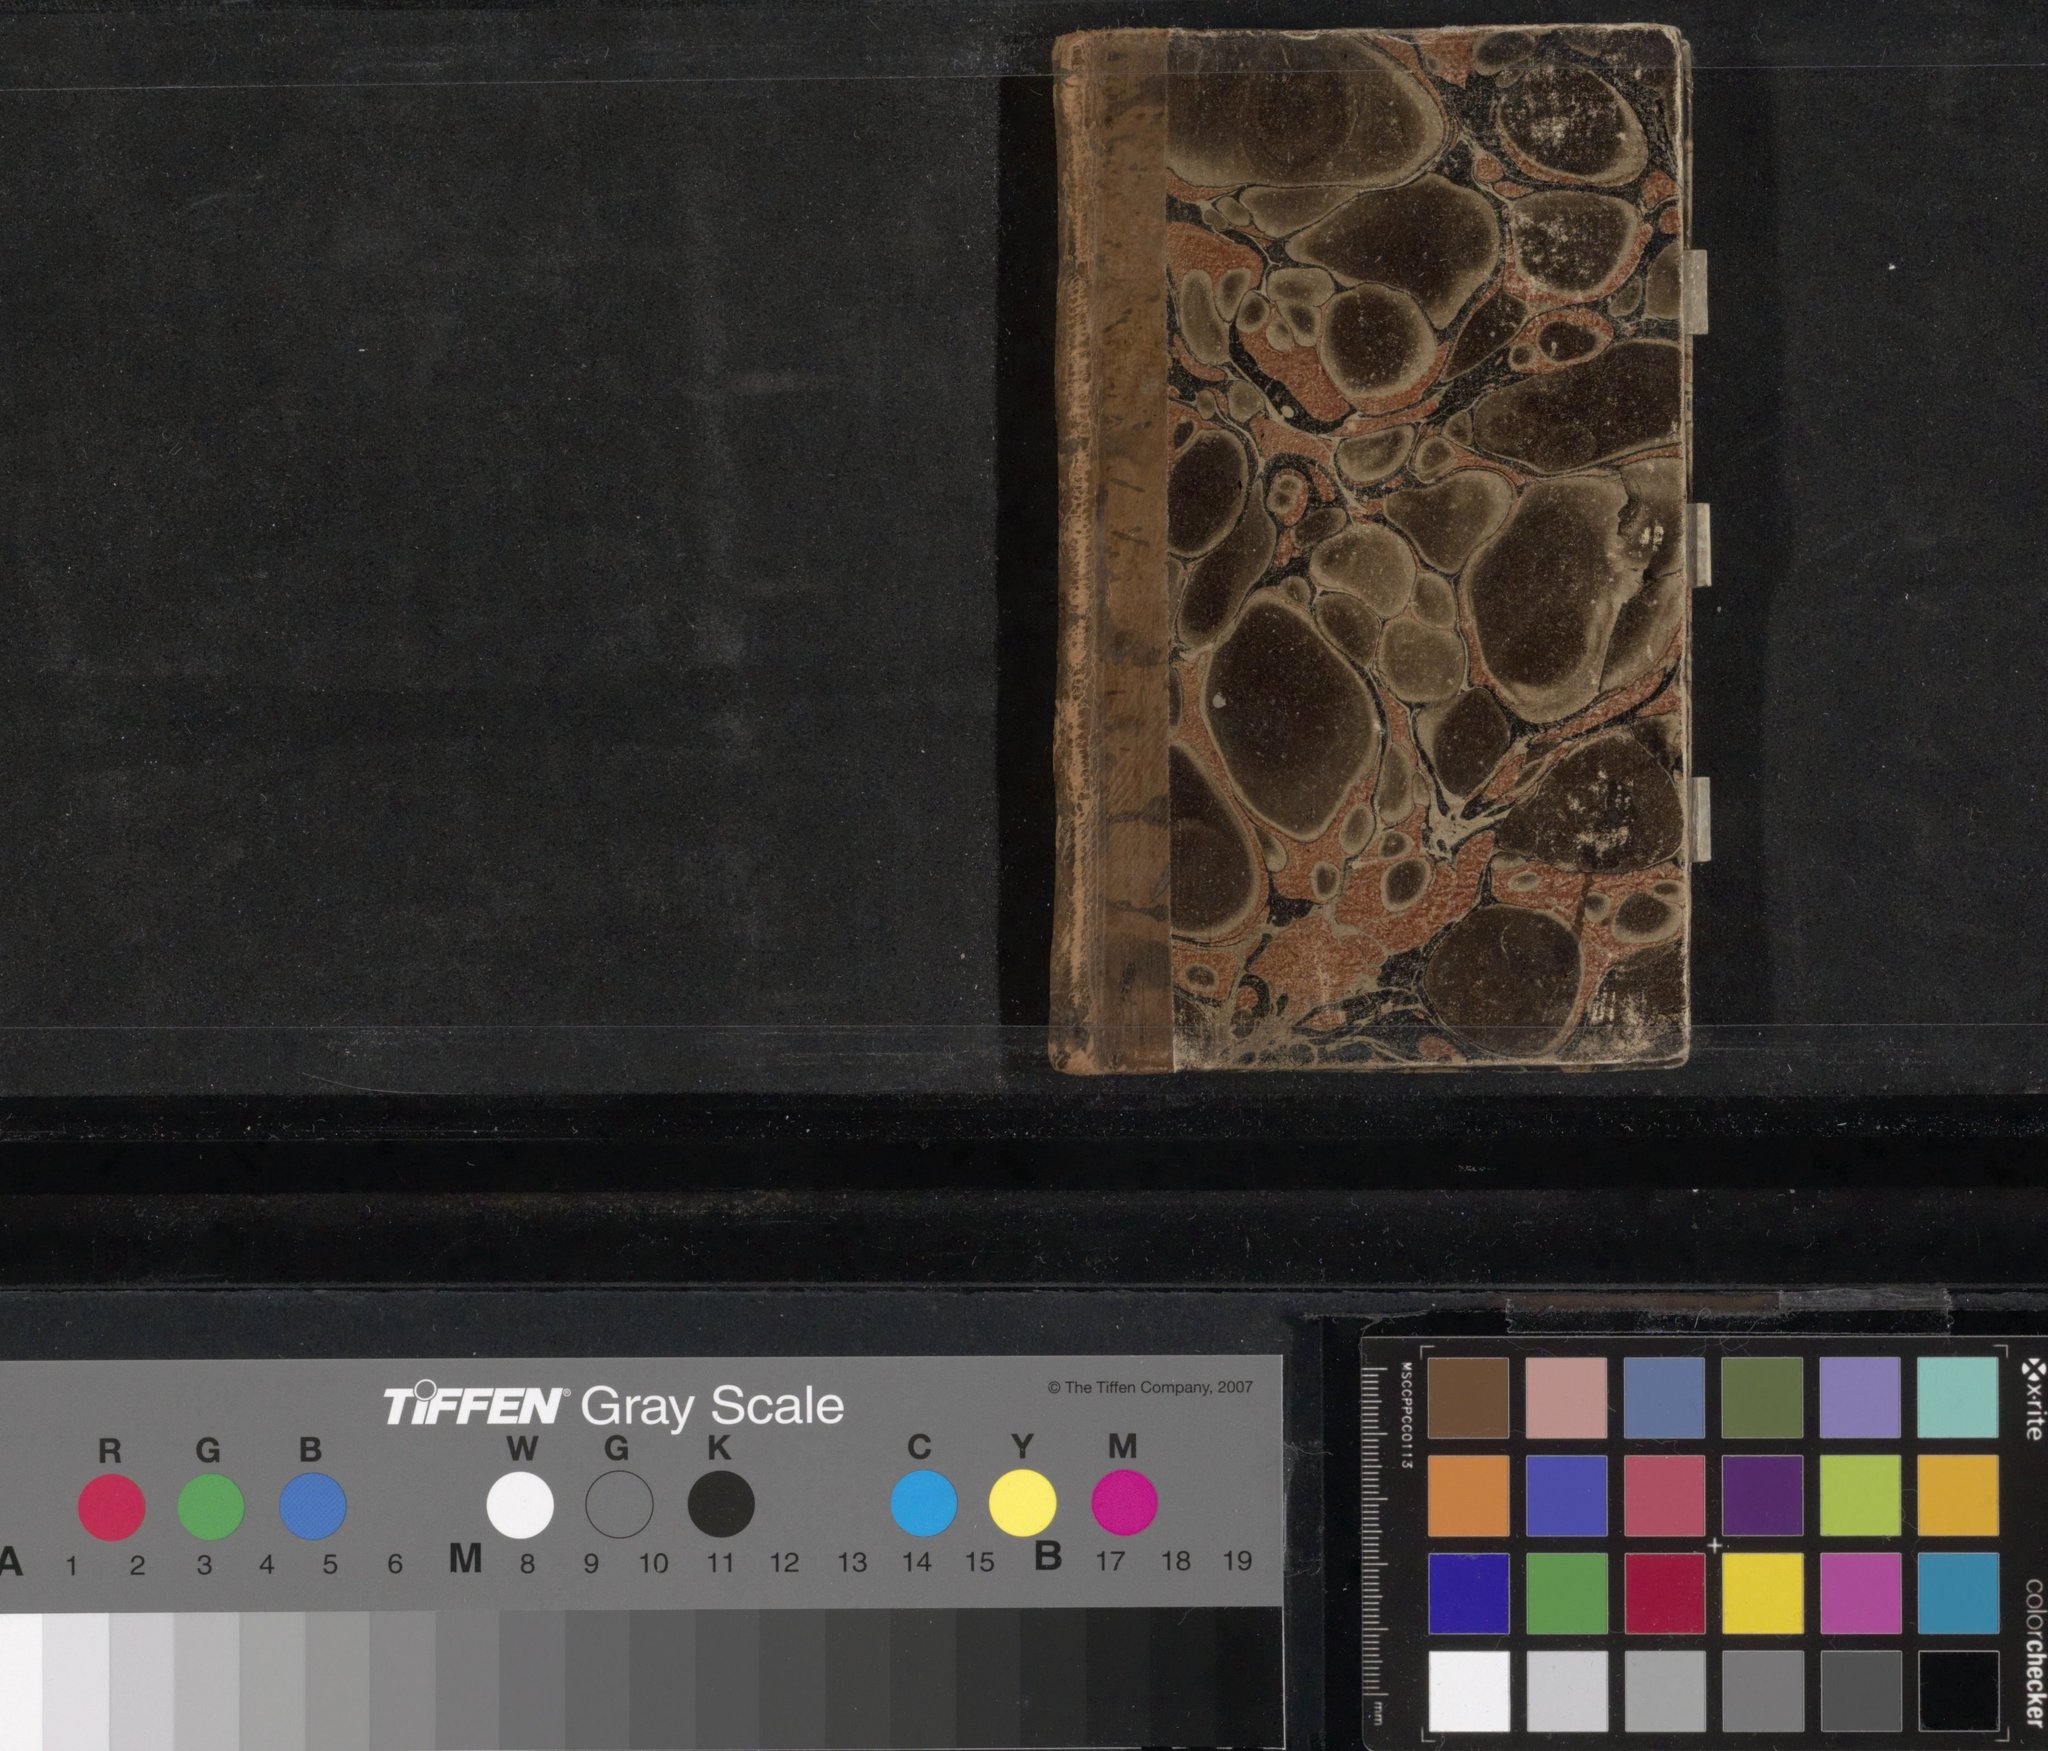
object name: sketchbook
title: Schetsboek met 47 bladen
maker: johannes tavenraat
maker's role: draughtsman, painter, print maker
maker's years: 1809-1881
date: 1866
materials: cardboard, ink, leather, paper, pencil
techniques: pen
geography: bohemia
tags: hoofed animals: deer, adult man, landscapes with waters, waterscapes, seascapes (in the temperate zone), windmill in landscape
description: Schetsboek bestaande uit 47 bladen met koppen, herten en landschappen. Slechts de voorste pagina's bevatten tekeningen.